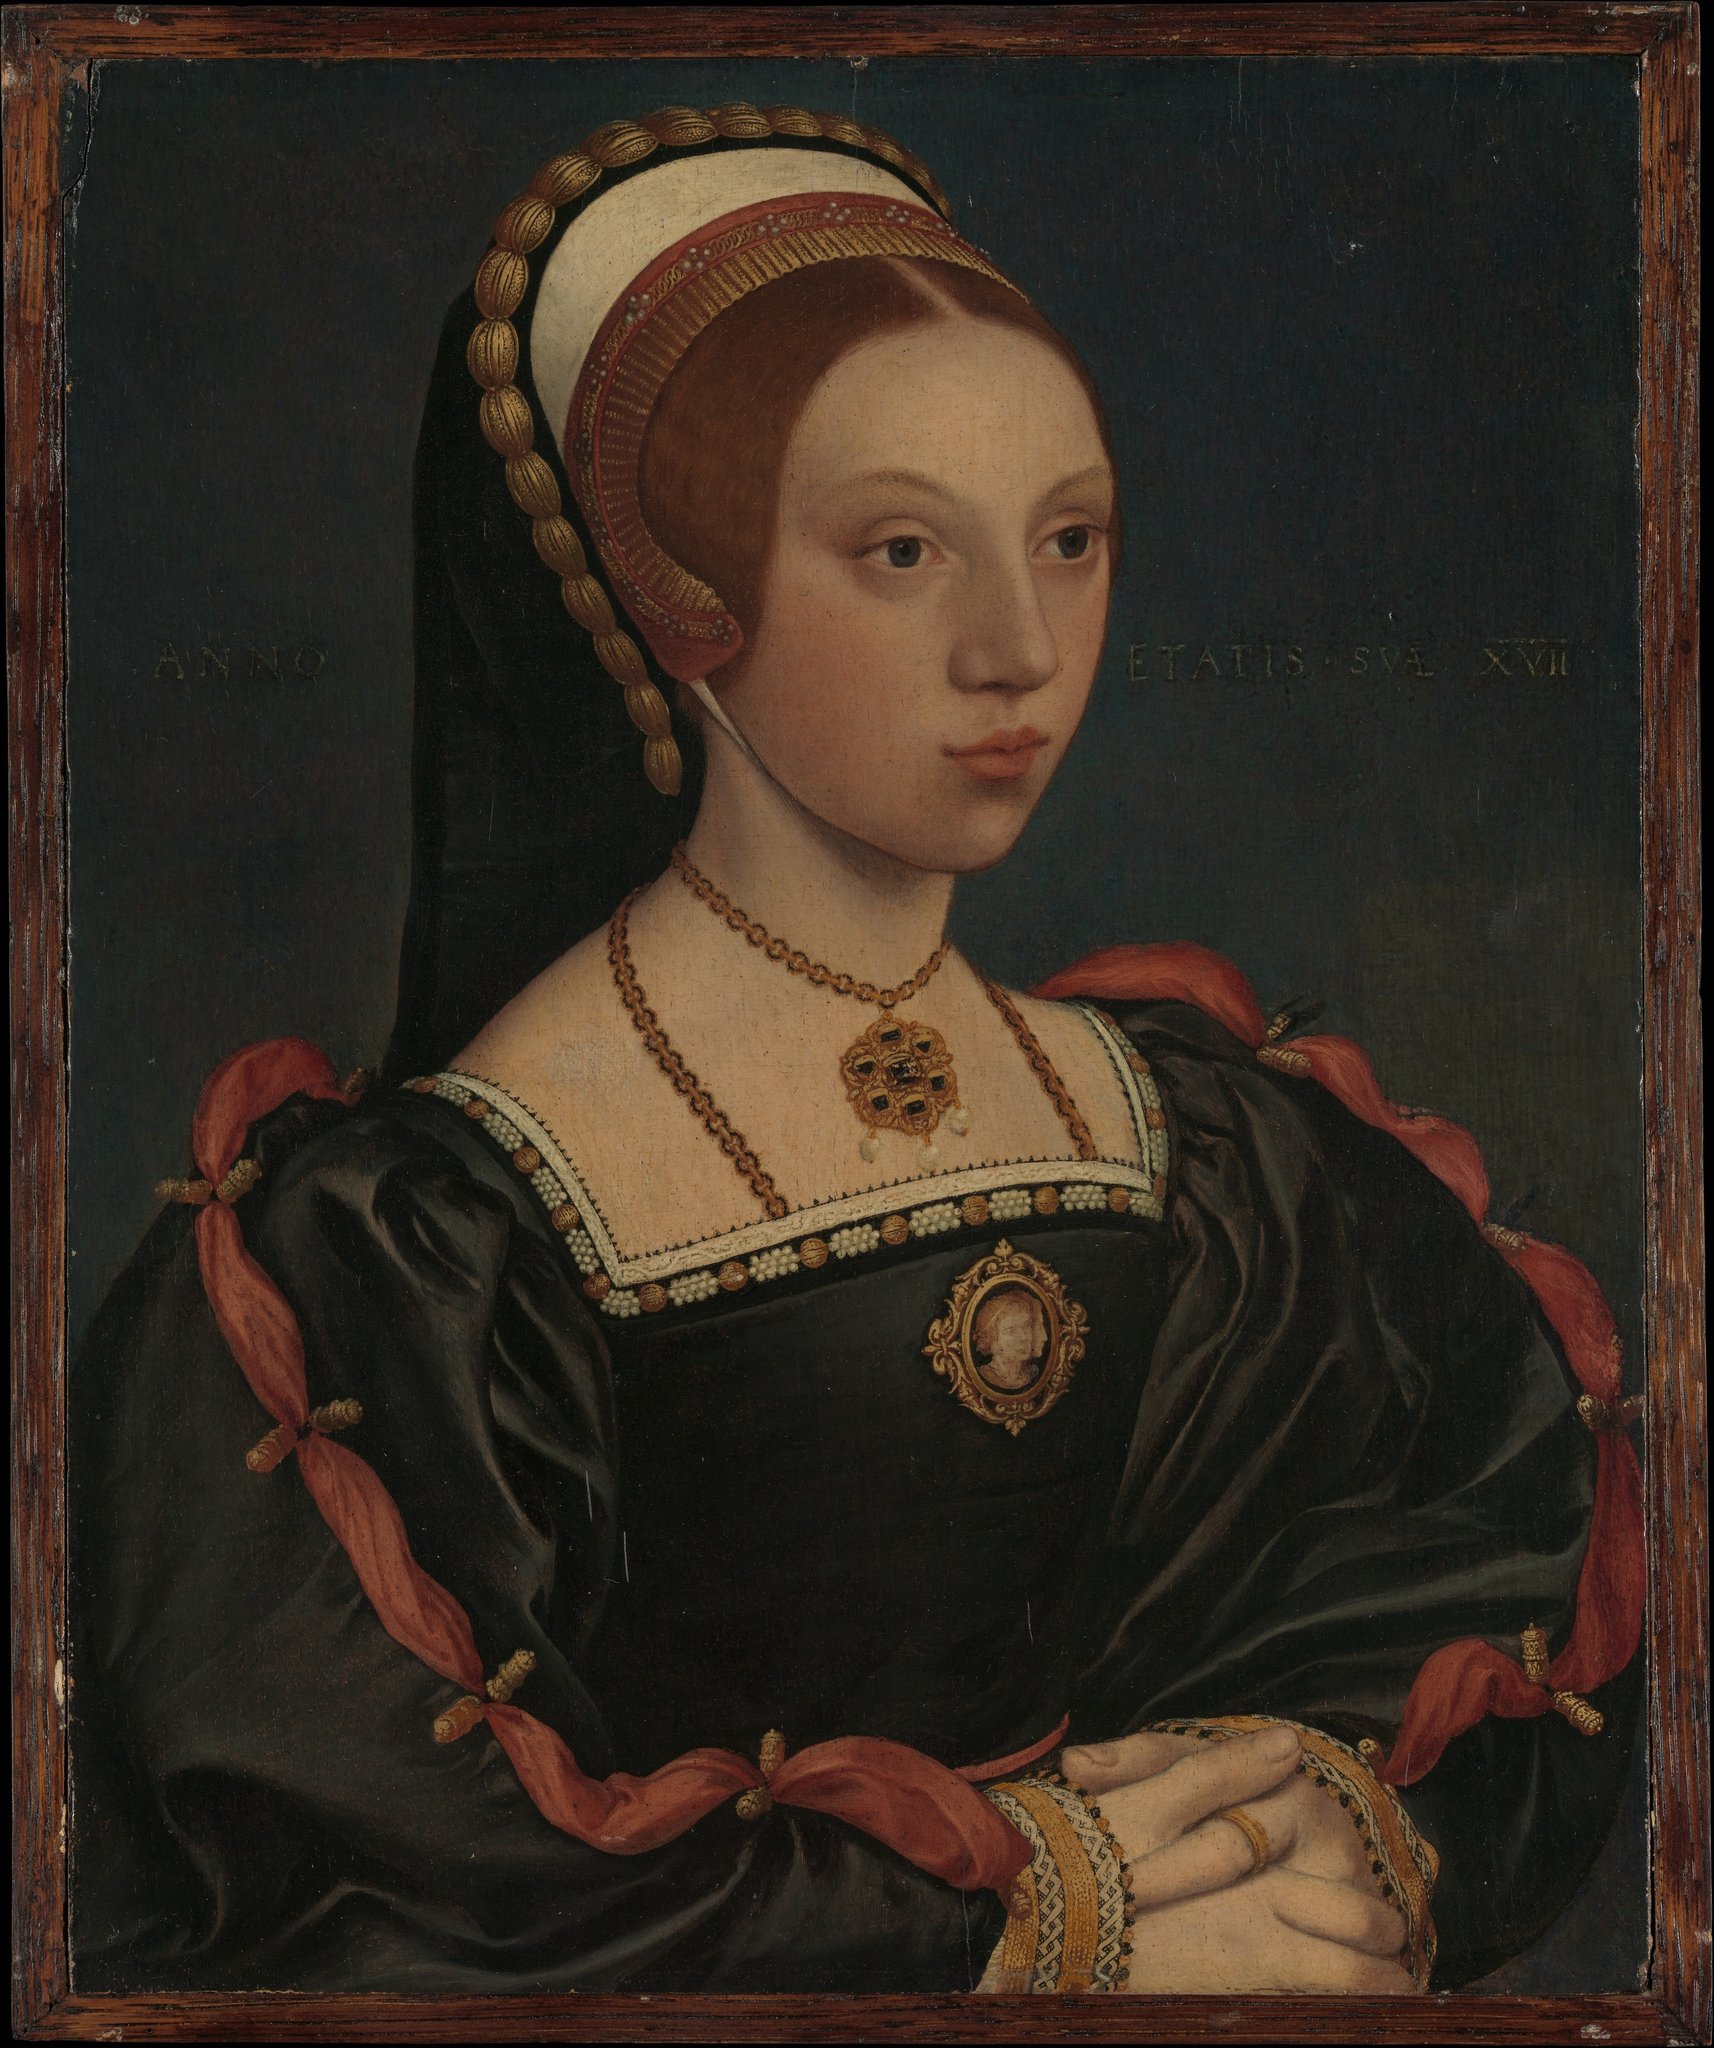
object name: painting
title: Portrait of a Young Woman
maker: hans holbein the younger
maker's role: artist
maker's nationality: german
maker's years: 1497-1543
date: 1540-1545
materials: gold, wood, oil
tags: portraits,women